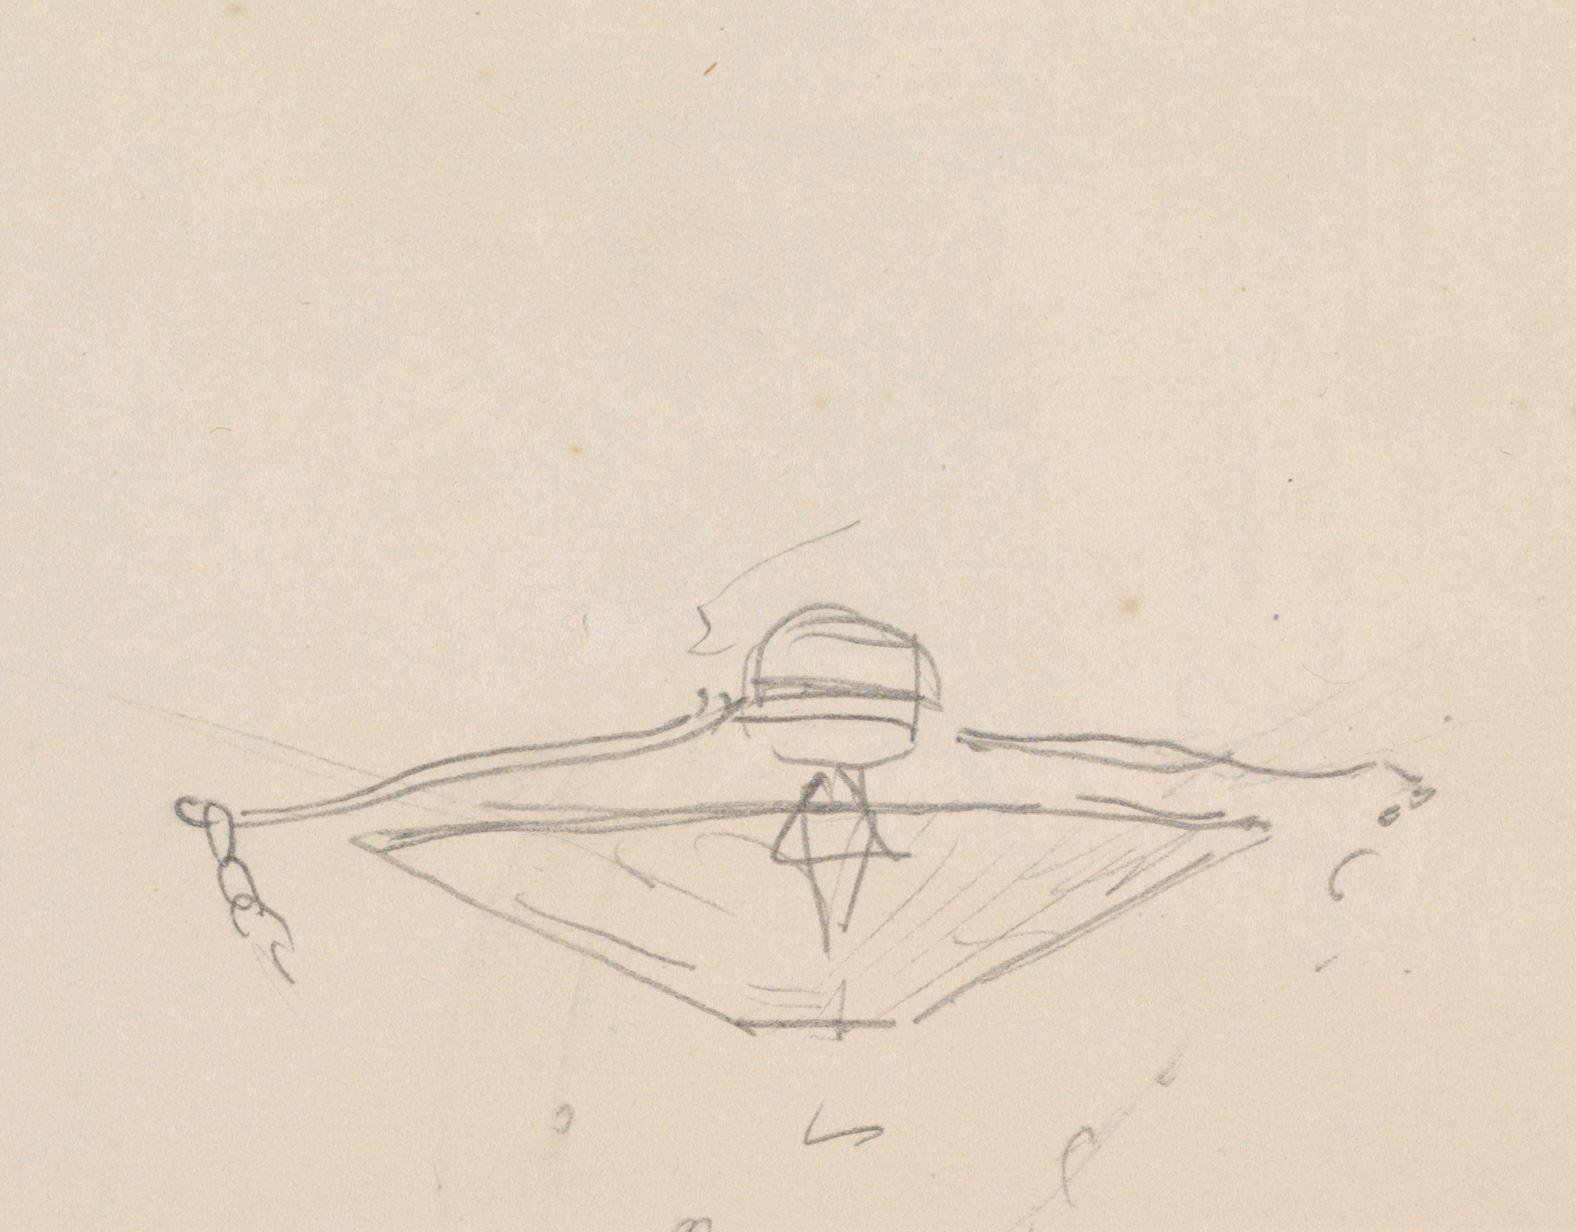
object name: sketchbook leaf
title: Studie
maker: george hendrik breitner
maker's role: draughtsman, painter, print maker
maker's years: 1857-1923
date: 1886-1891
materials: paper, pencil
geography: amsterdam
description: Pagina 32 uit een schetsboek met 32 bladen.